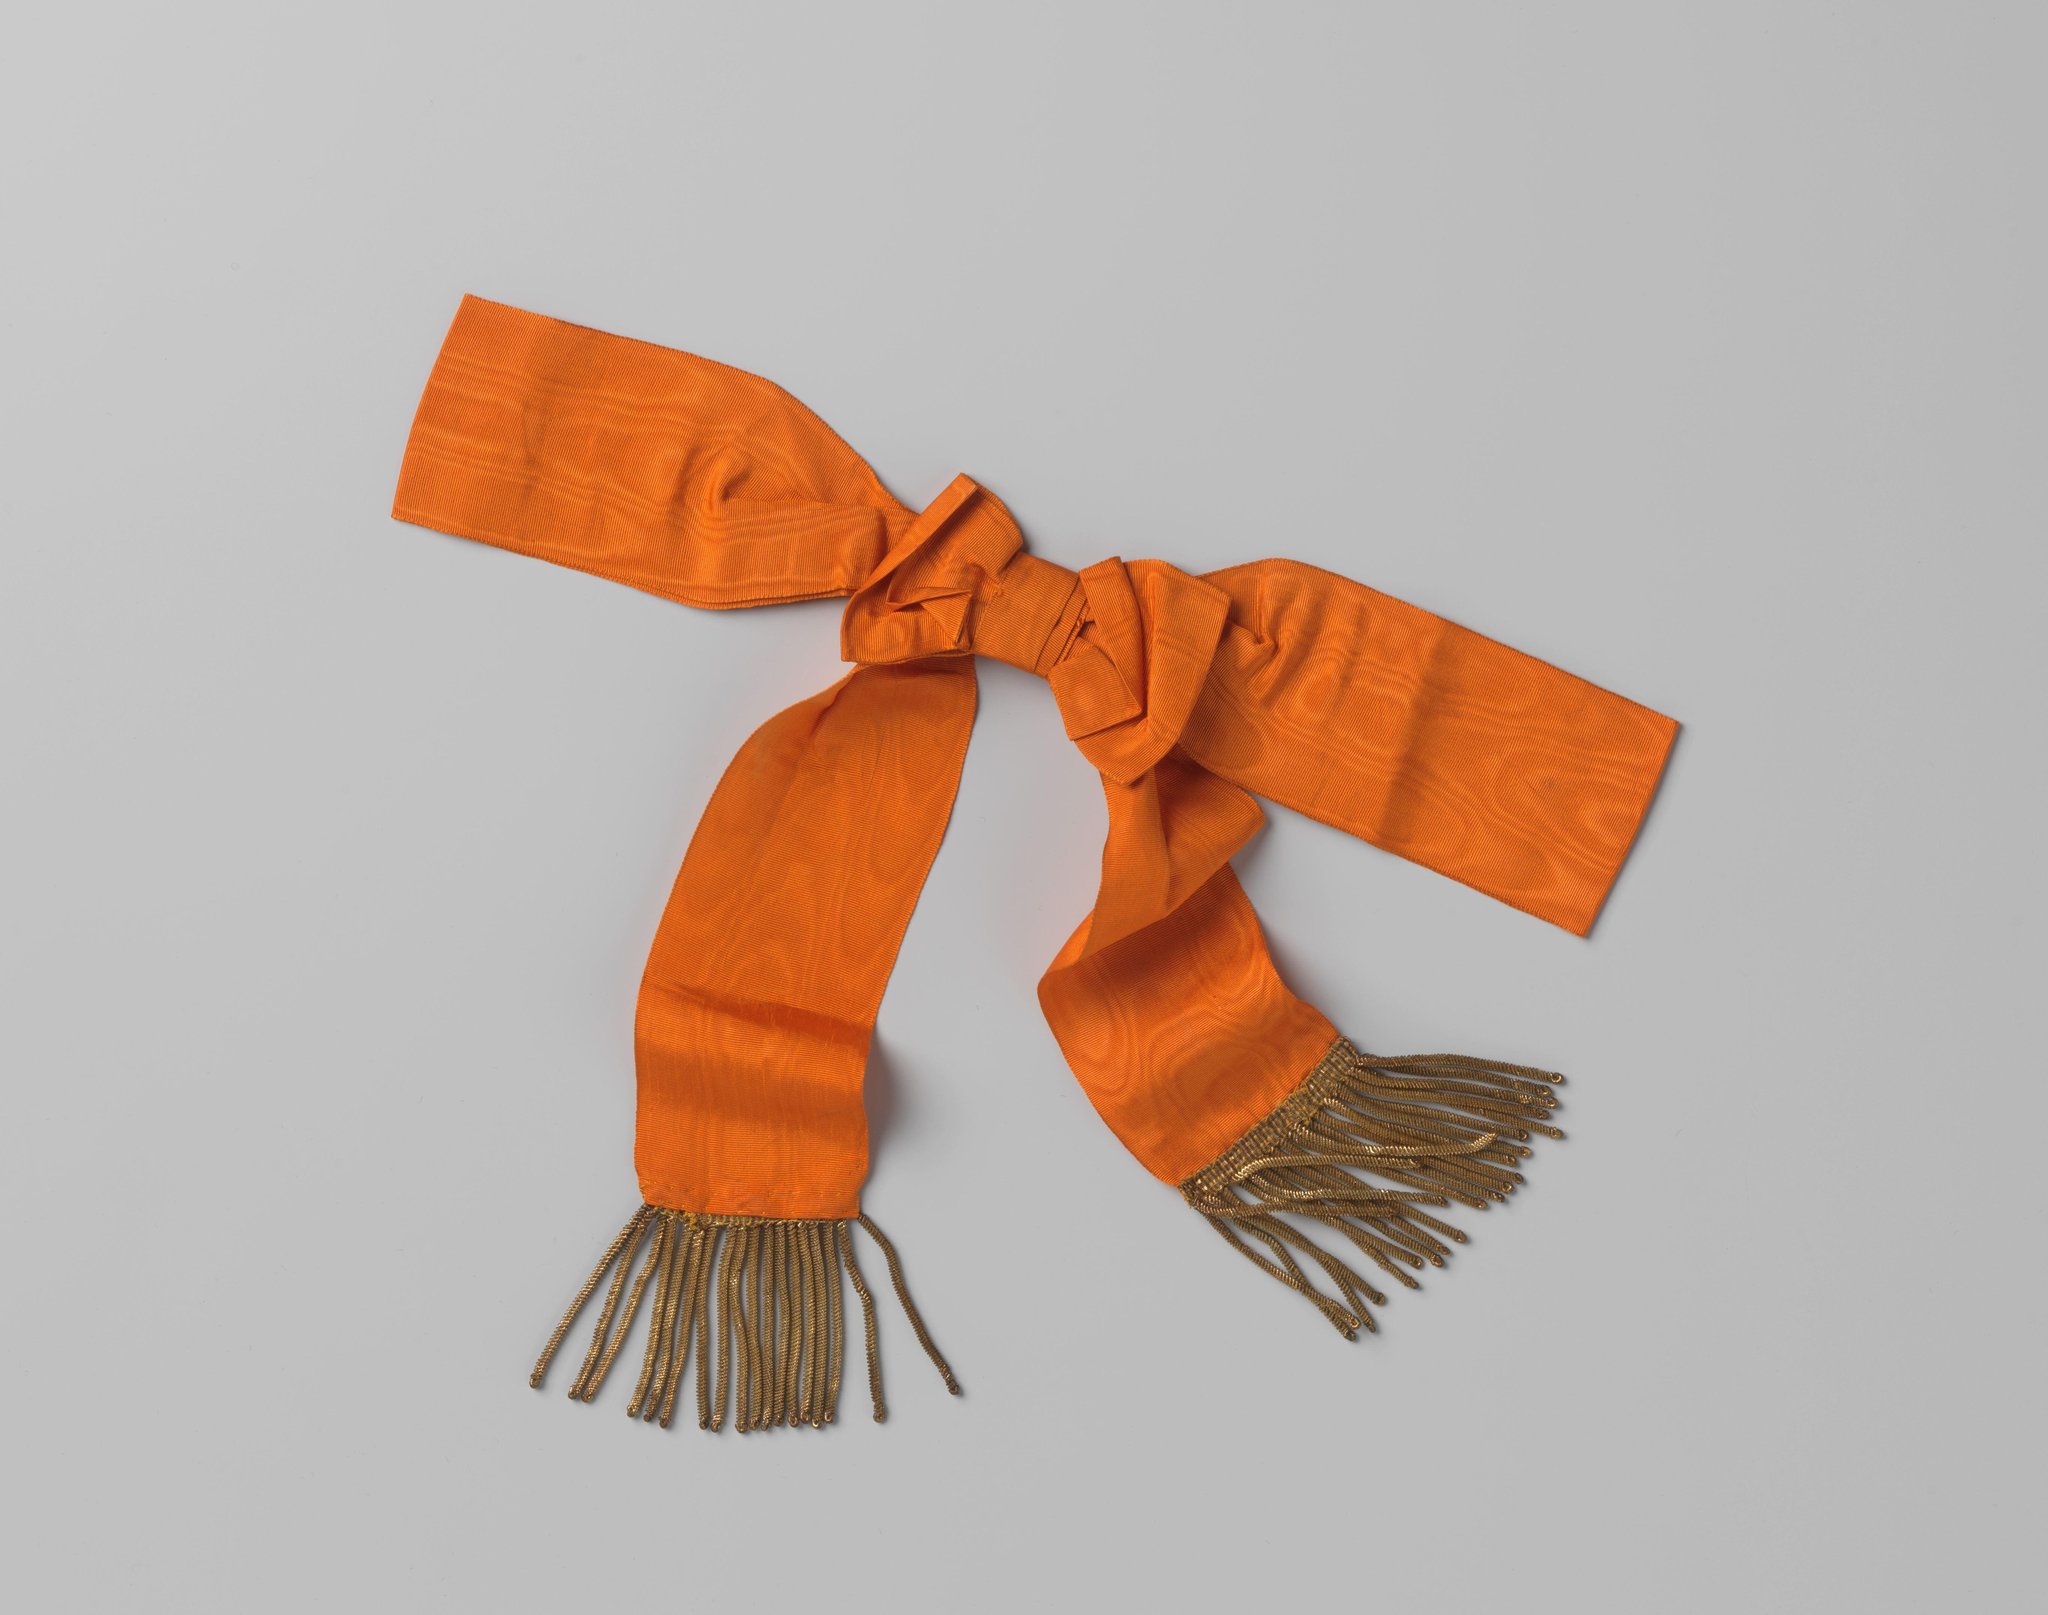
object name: cockade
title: Kokarde van gala-kostuum van lid Erewacht tijdens de inhuldiging van koningin Juliana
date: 1909-1948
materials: ribbon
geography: netherlands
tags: erich hartmann, the hague, juliana of the netherlands, amsterdam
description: Oranje kokarde met veiligheidsspeld. Gedragen door Ernst Hartmann, lid Erewacht, tijdens de inhuldiging van koningin Juliana op 6 september 1948.